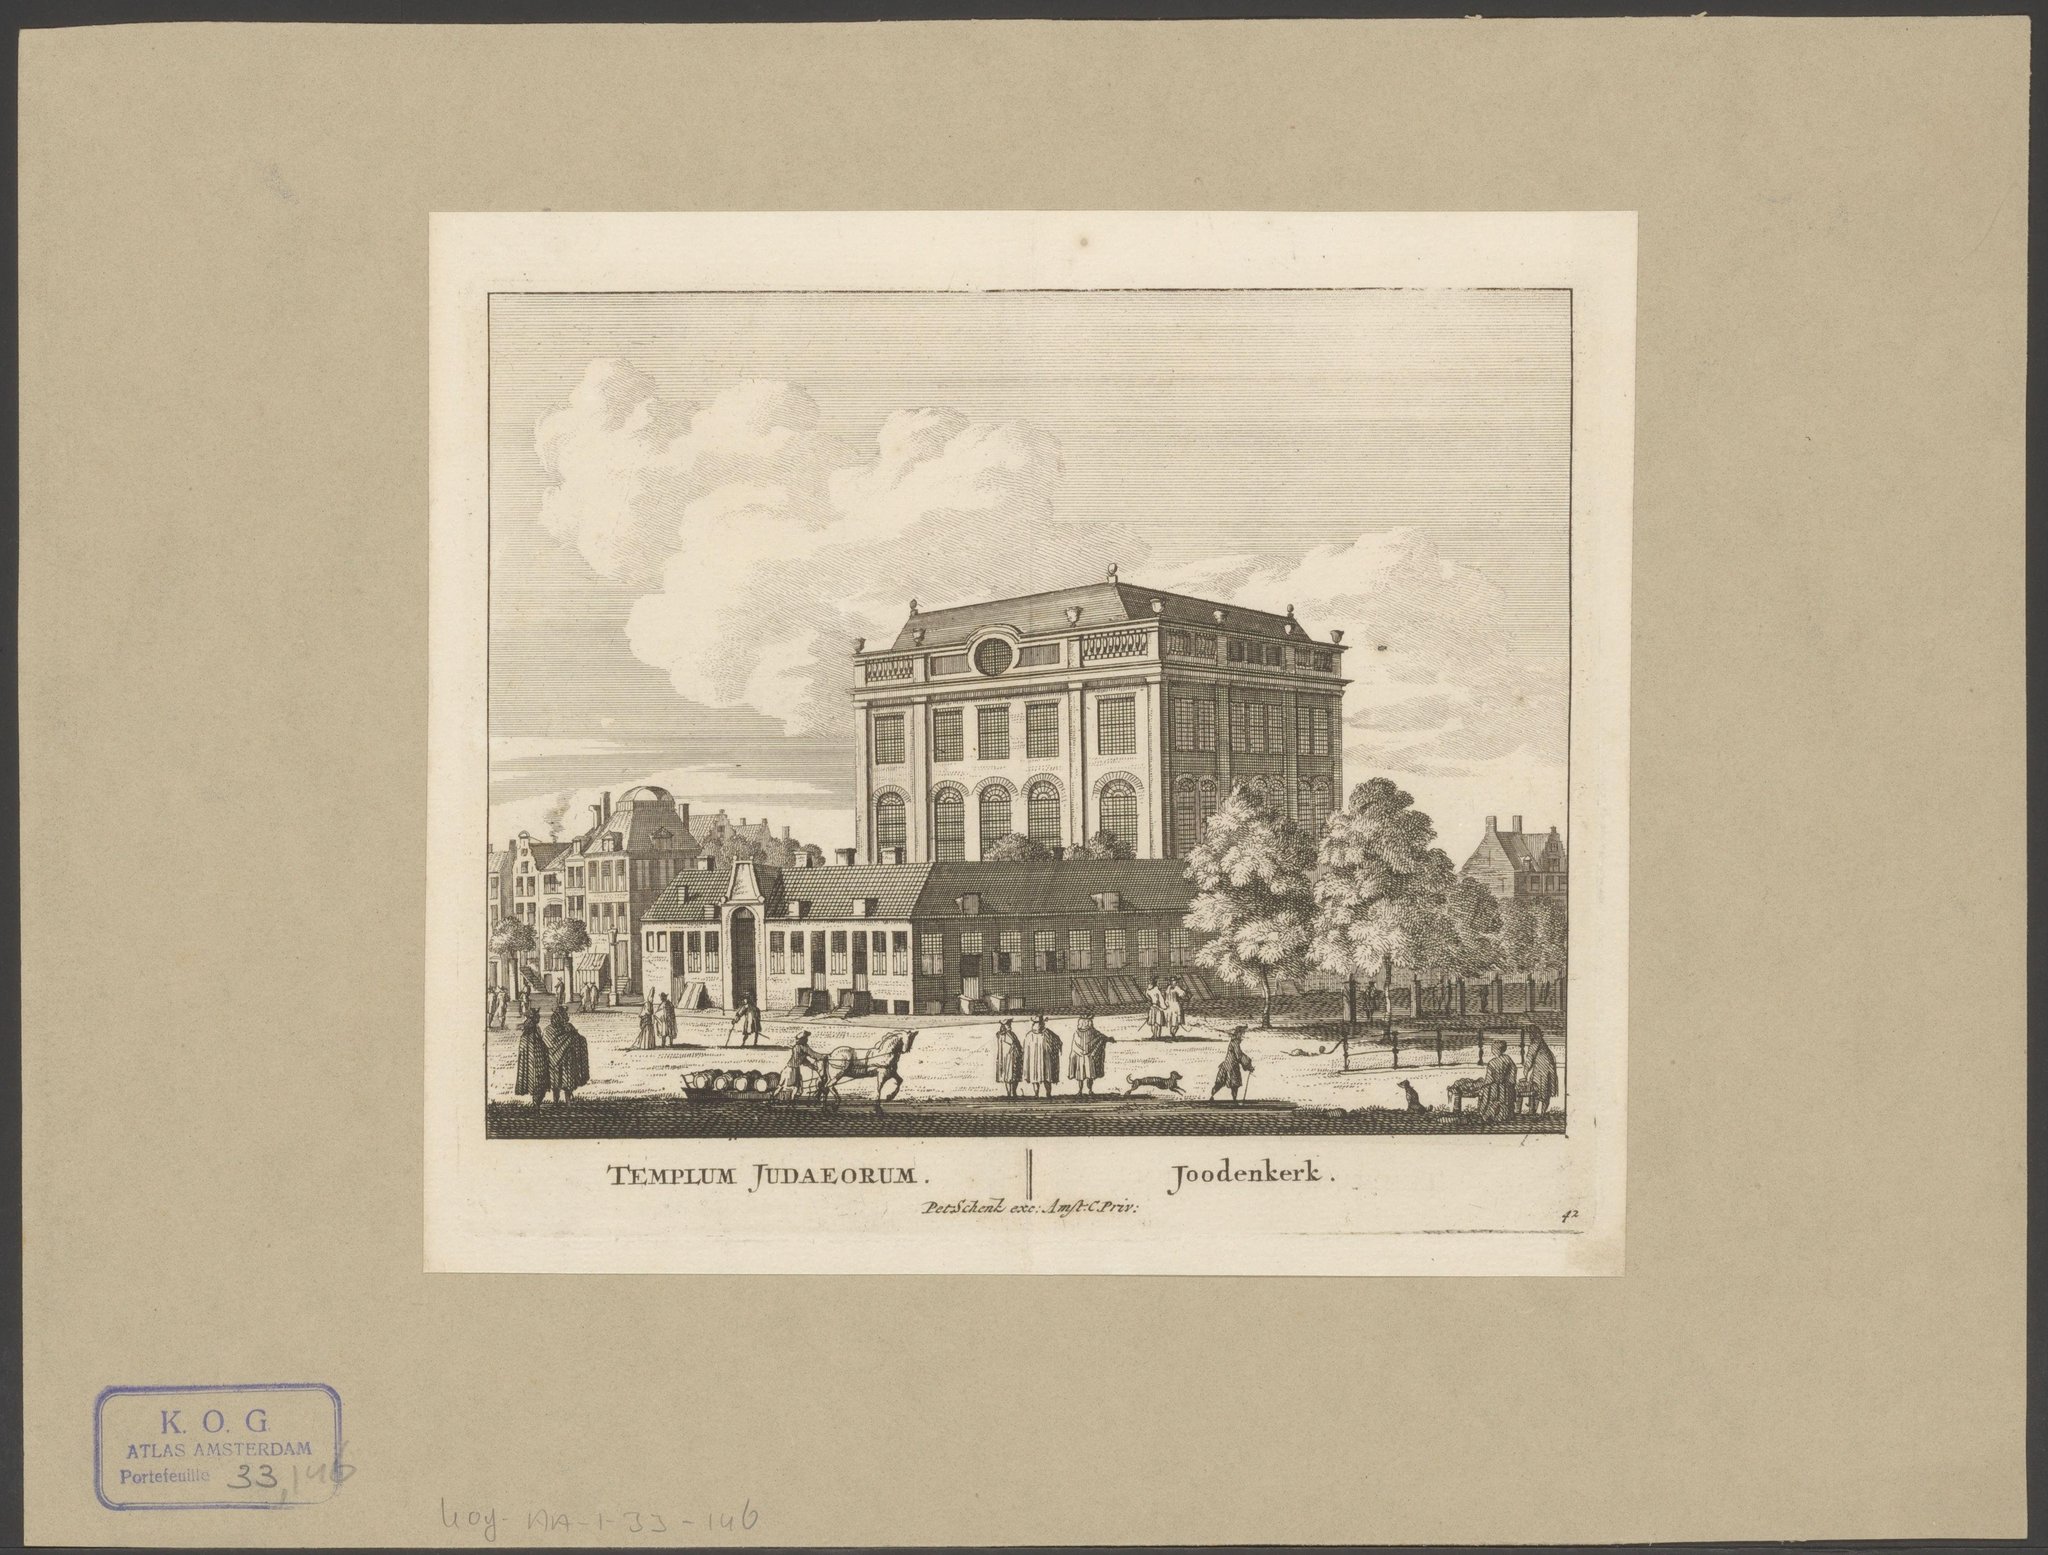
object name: print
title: 100 Afbeeldinge der voornaamste gebouwen van Amsterdam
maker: Anonymous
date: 1710-1711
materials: paper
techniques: engraving, etching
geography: northern netherlands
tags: the synagogue (as building and place of worship ~ jewish religion), street (+ city(-scape) with figures, staffage)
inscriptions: collector's mark: Lugt 1641b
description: Prent mogelijk uit: 100 Afbeeldinge der voornaamste gebouwen van Amsterdam. Amsterdam: Pieter Schenk (I), s.a. [1710-1711]. Of uit: 100 Afbeeldinge der voornaamste gebouwen van Amsterdam. Amsterdam: Barent Greve, s.a. [1757-1766]. In de tweede uitgave, uitgegeven door Barent Greve, is alleen de titelprent aangepast. De overige prenten zijn onveranderd gebleven.